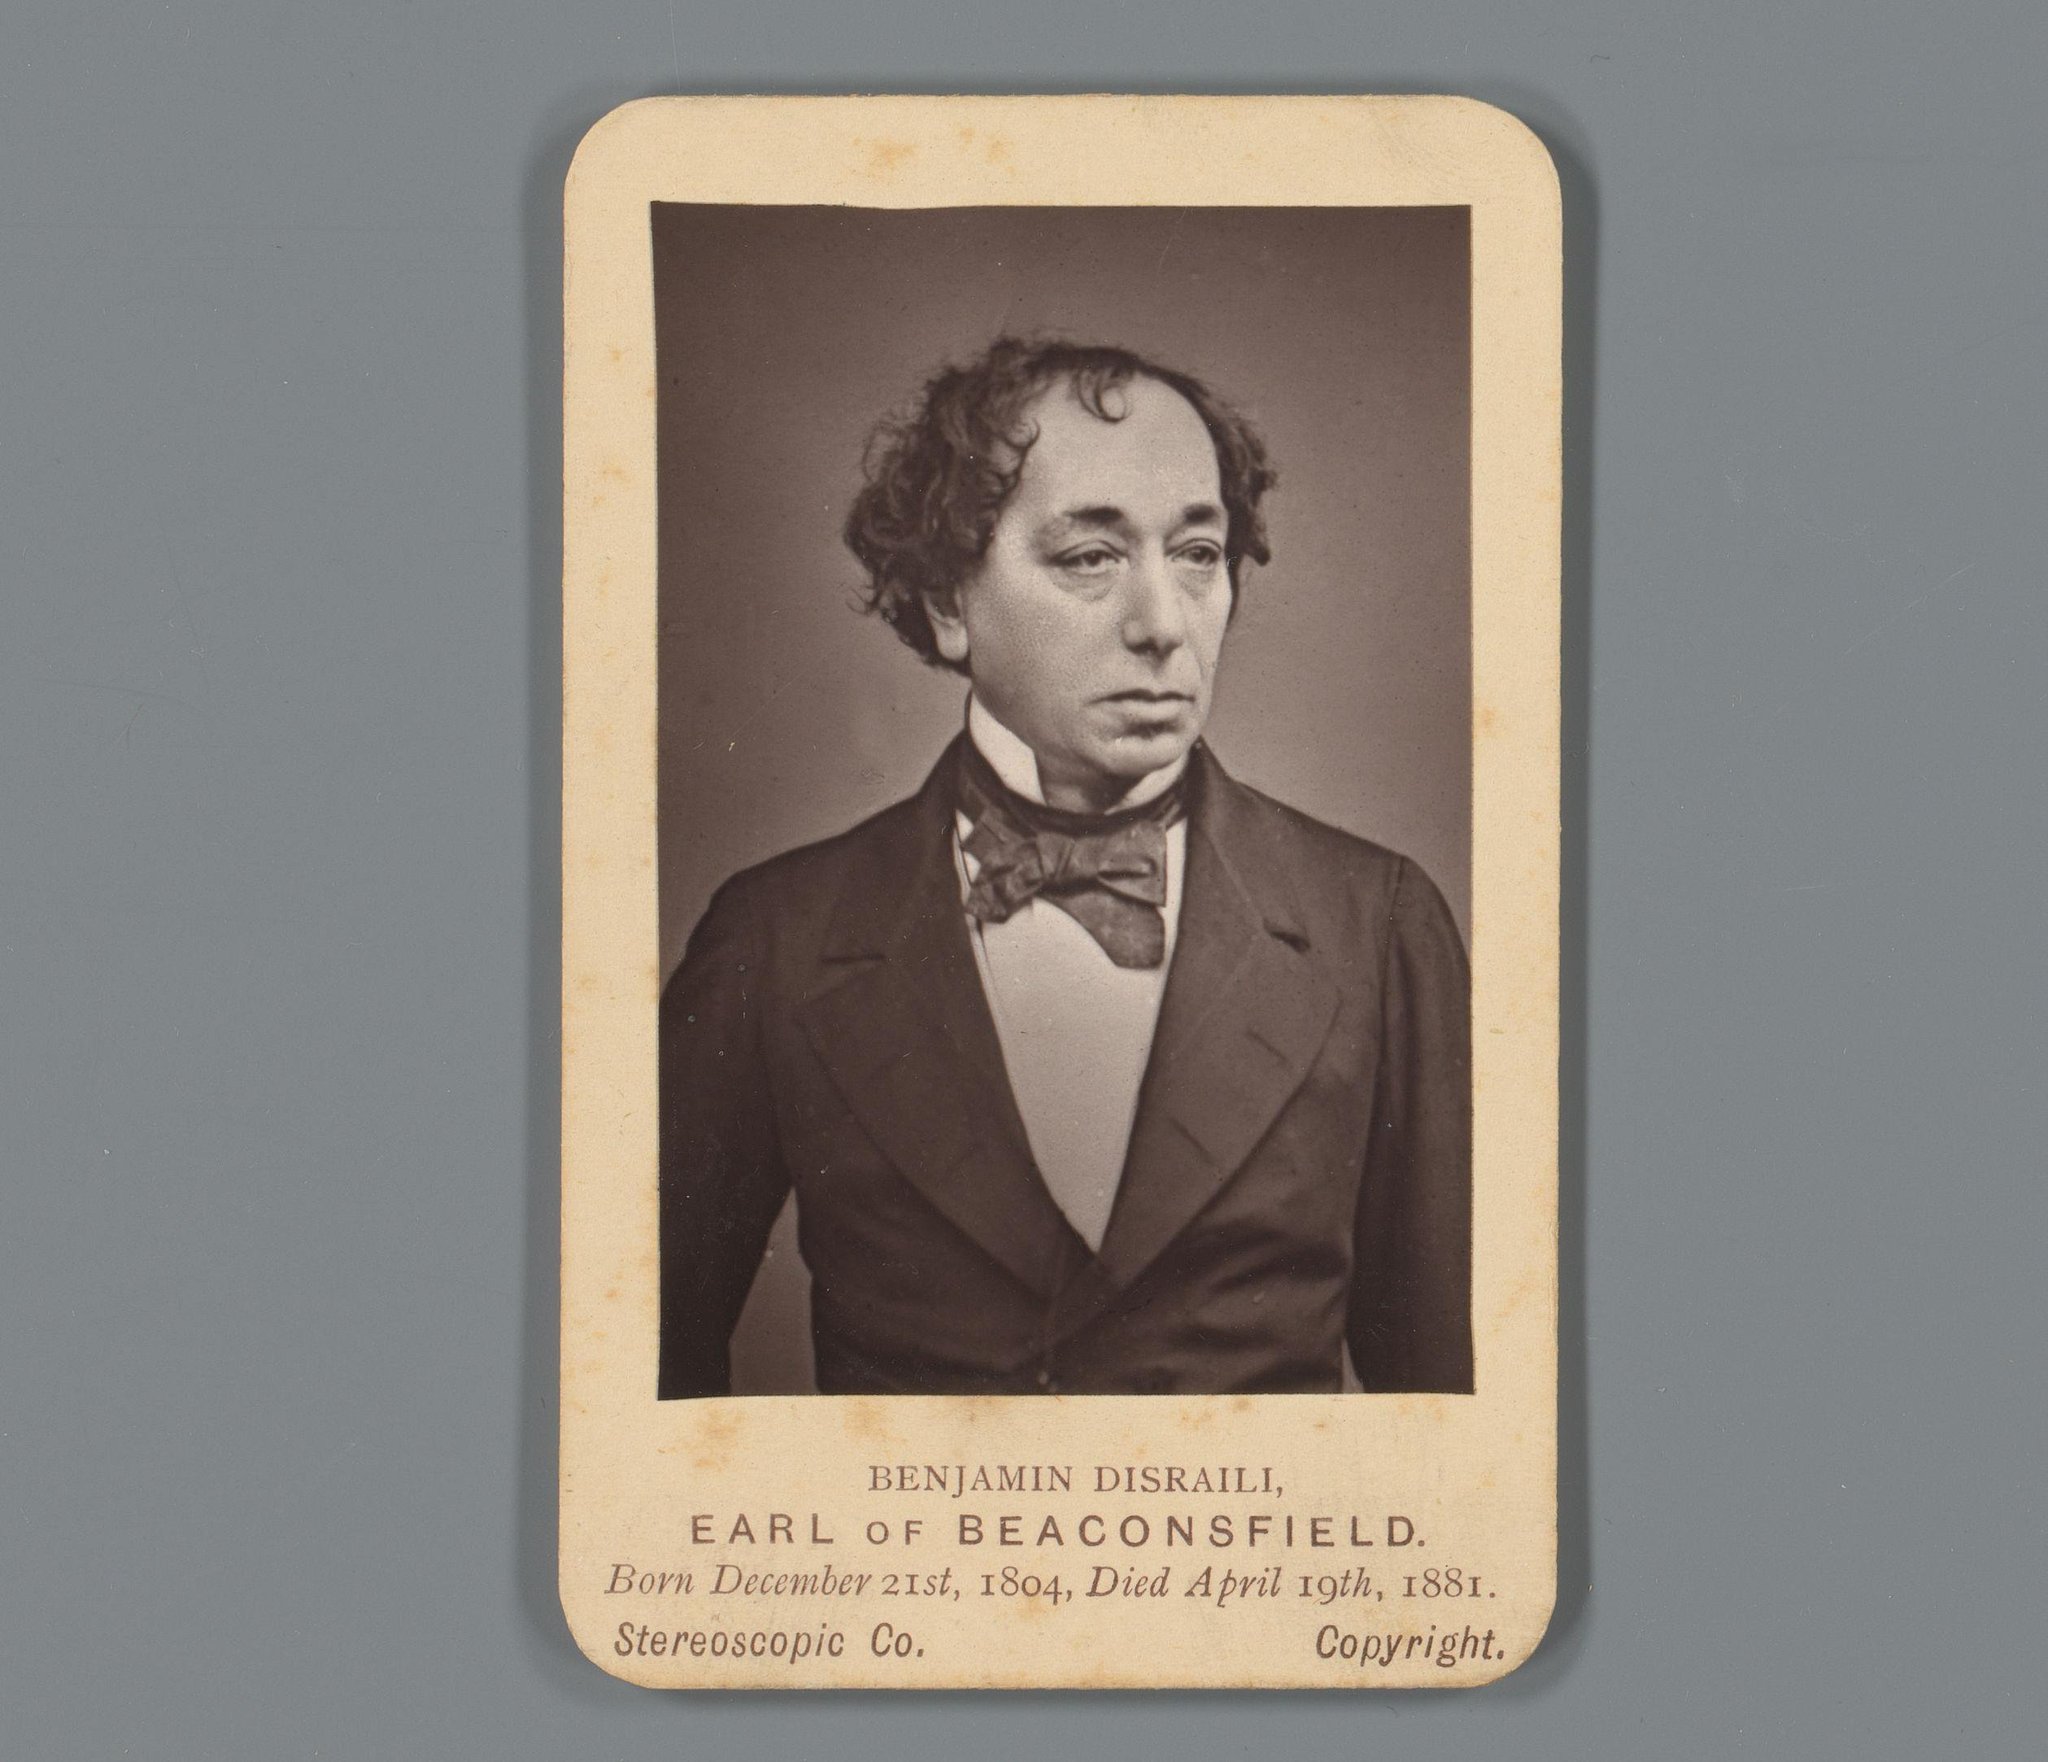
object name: photomechanical print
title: Portret van Benjamin Disraeli met reclame voor The Anchor Restaurant in Londen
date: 1881-1940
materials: cardboard, photographic support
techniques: woodburytype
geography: london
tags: politician, advertising, historical persons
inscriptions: inscription: ‘Born December 21st, 1804, Died April 19th, 1881./ Stereoscopic Co. Copyright.’